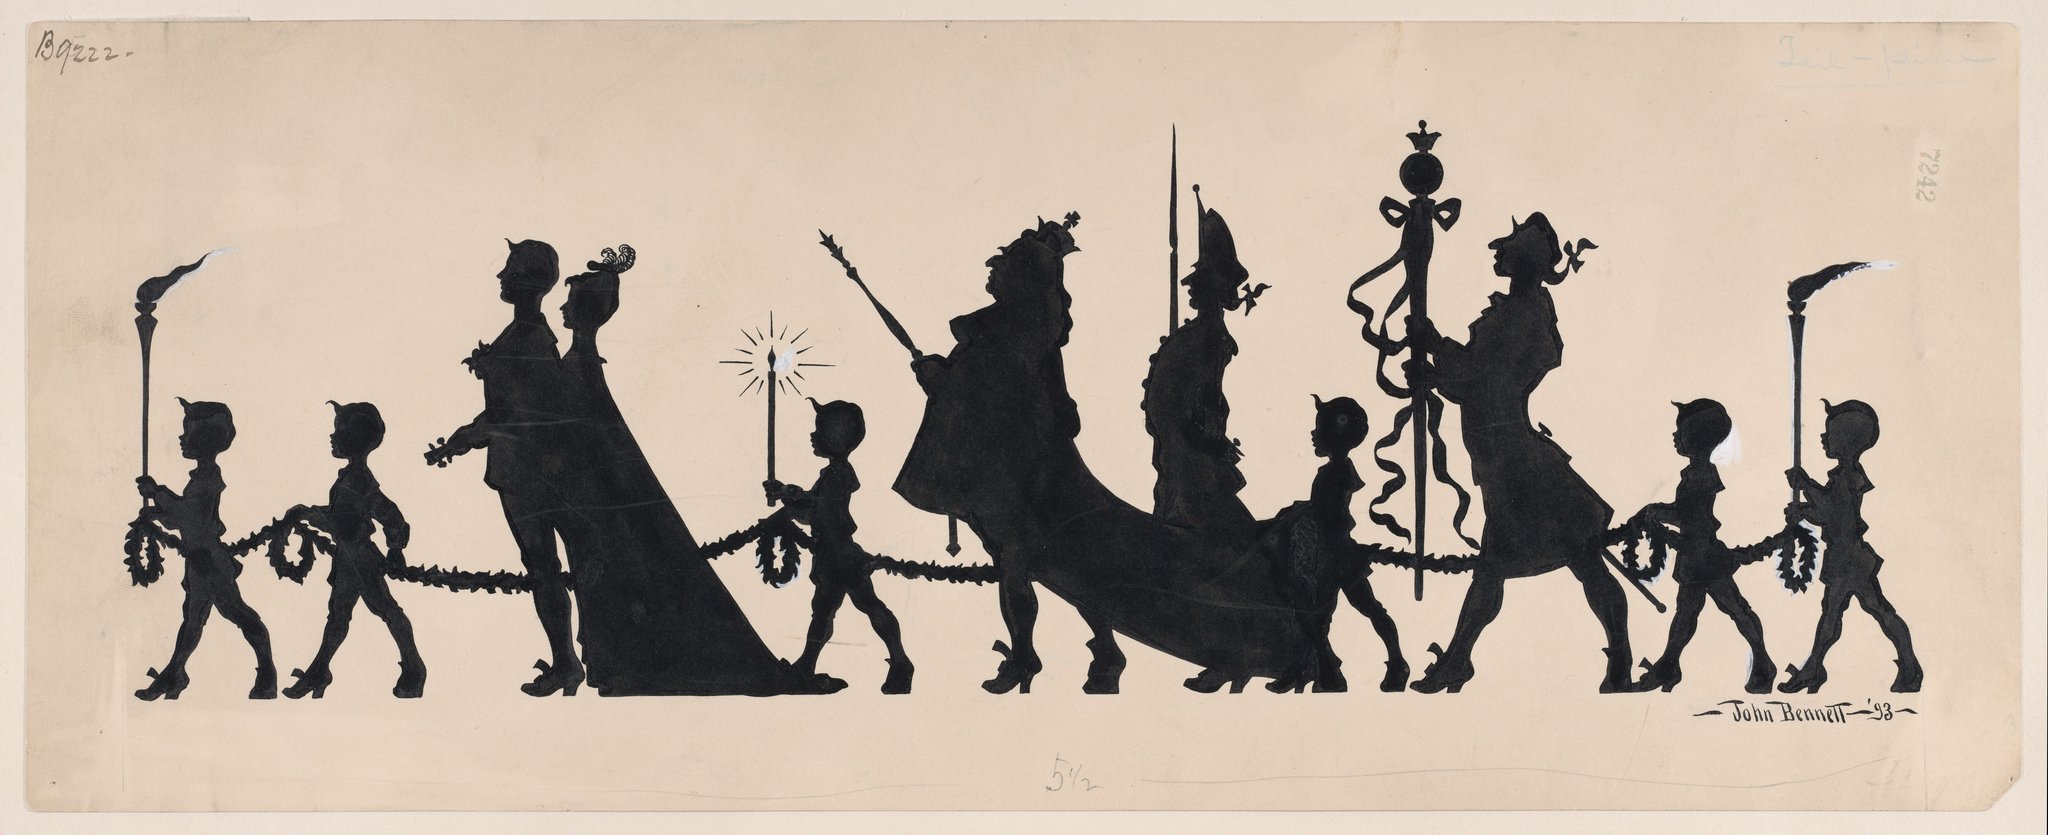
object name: cut paper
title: Tailpiece, silhouette of a king in procession with courtiers and page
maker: john bennett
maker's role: artist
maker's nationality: american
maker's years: 1840-1907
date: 1893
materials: paper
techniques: cutting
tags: kings,children,men,women,processions